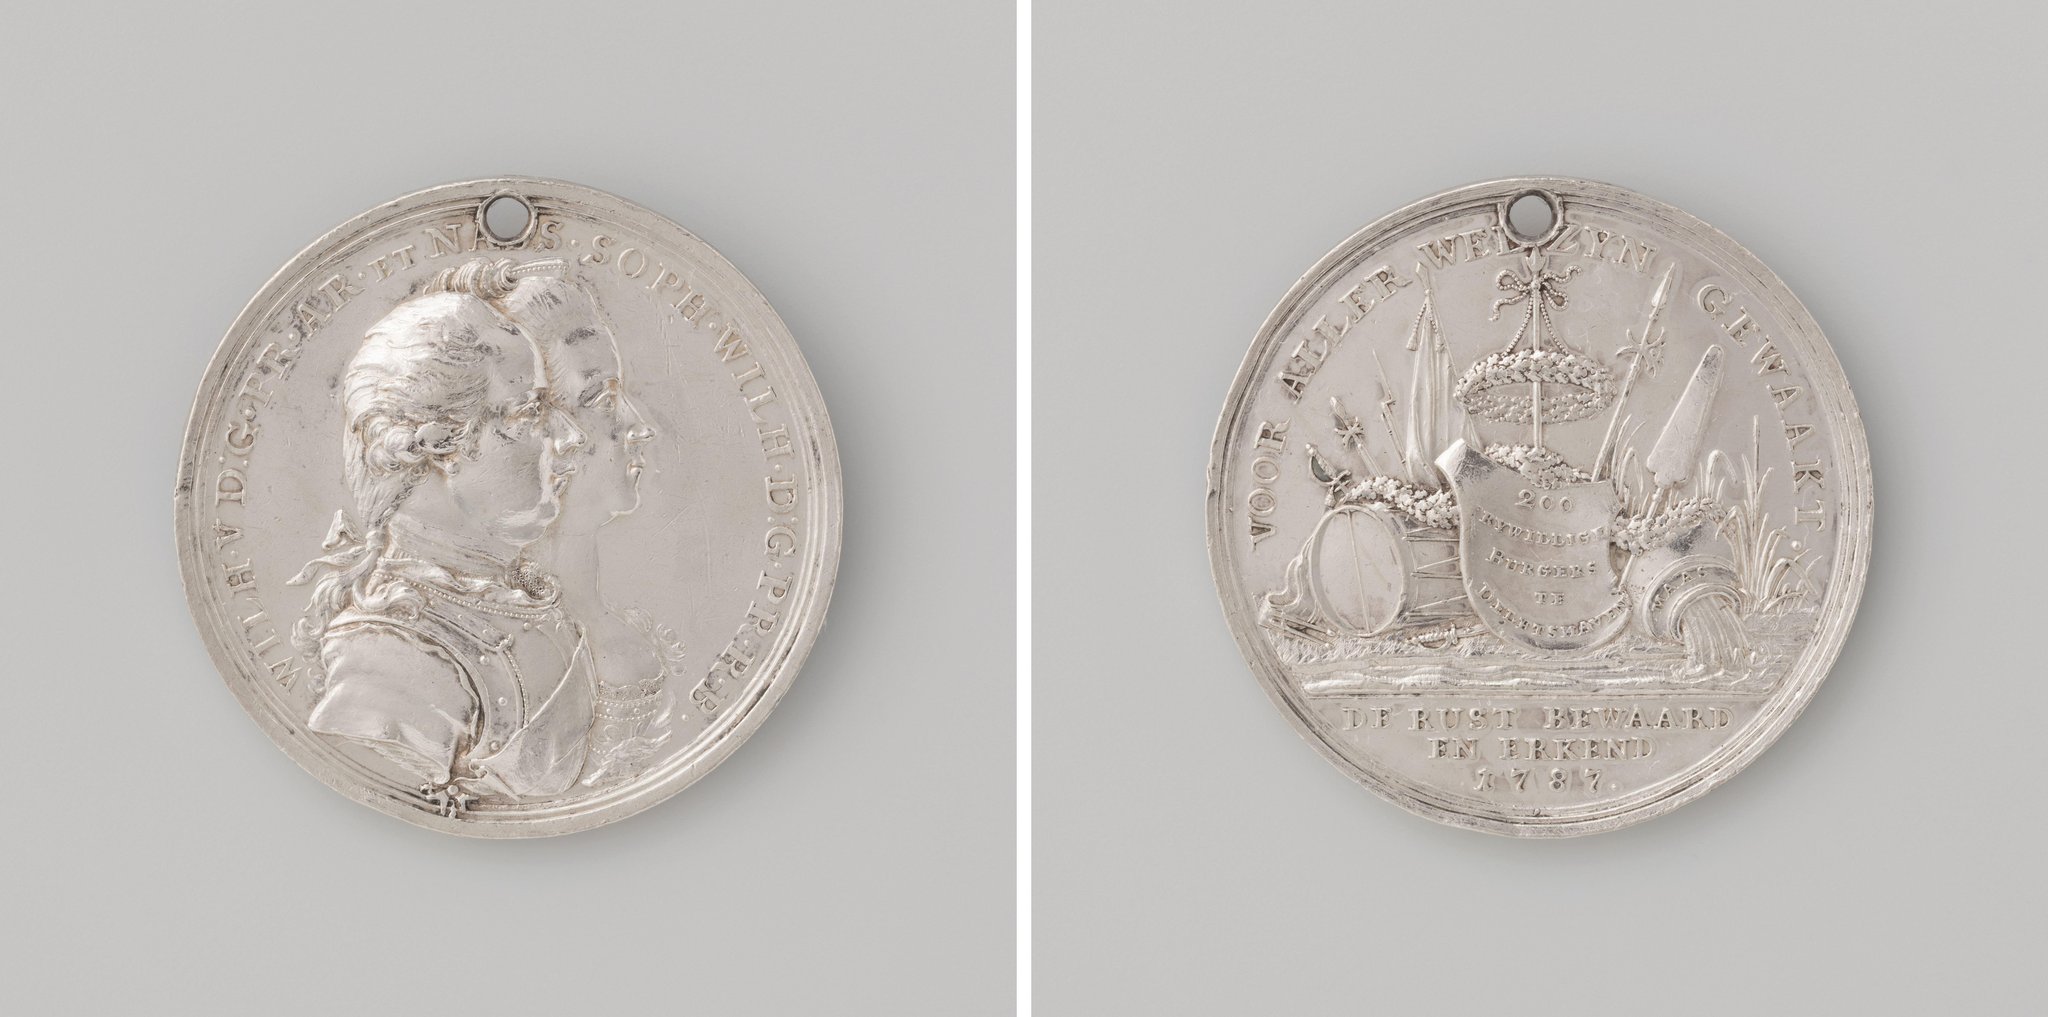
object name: history medal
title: Bezetting van Delfshaven, ter ere van Willem V, prins van Oranje-Nassau en Wilhelmina van Pruisen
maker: johan george holtzhey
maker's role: mintmaster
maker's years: 1726-1808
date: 1787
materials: silver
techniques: striking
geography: amsterdam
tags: william v (prince of orange), berlin, painter, draughtsman, wilhelmina of prussia (princess of orange), delfshaven